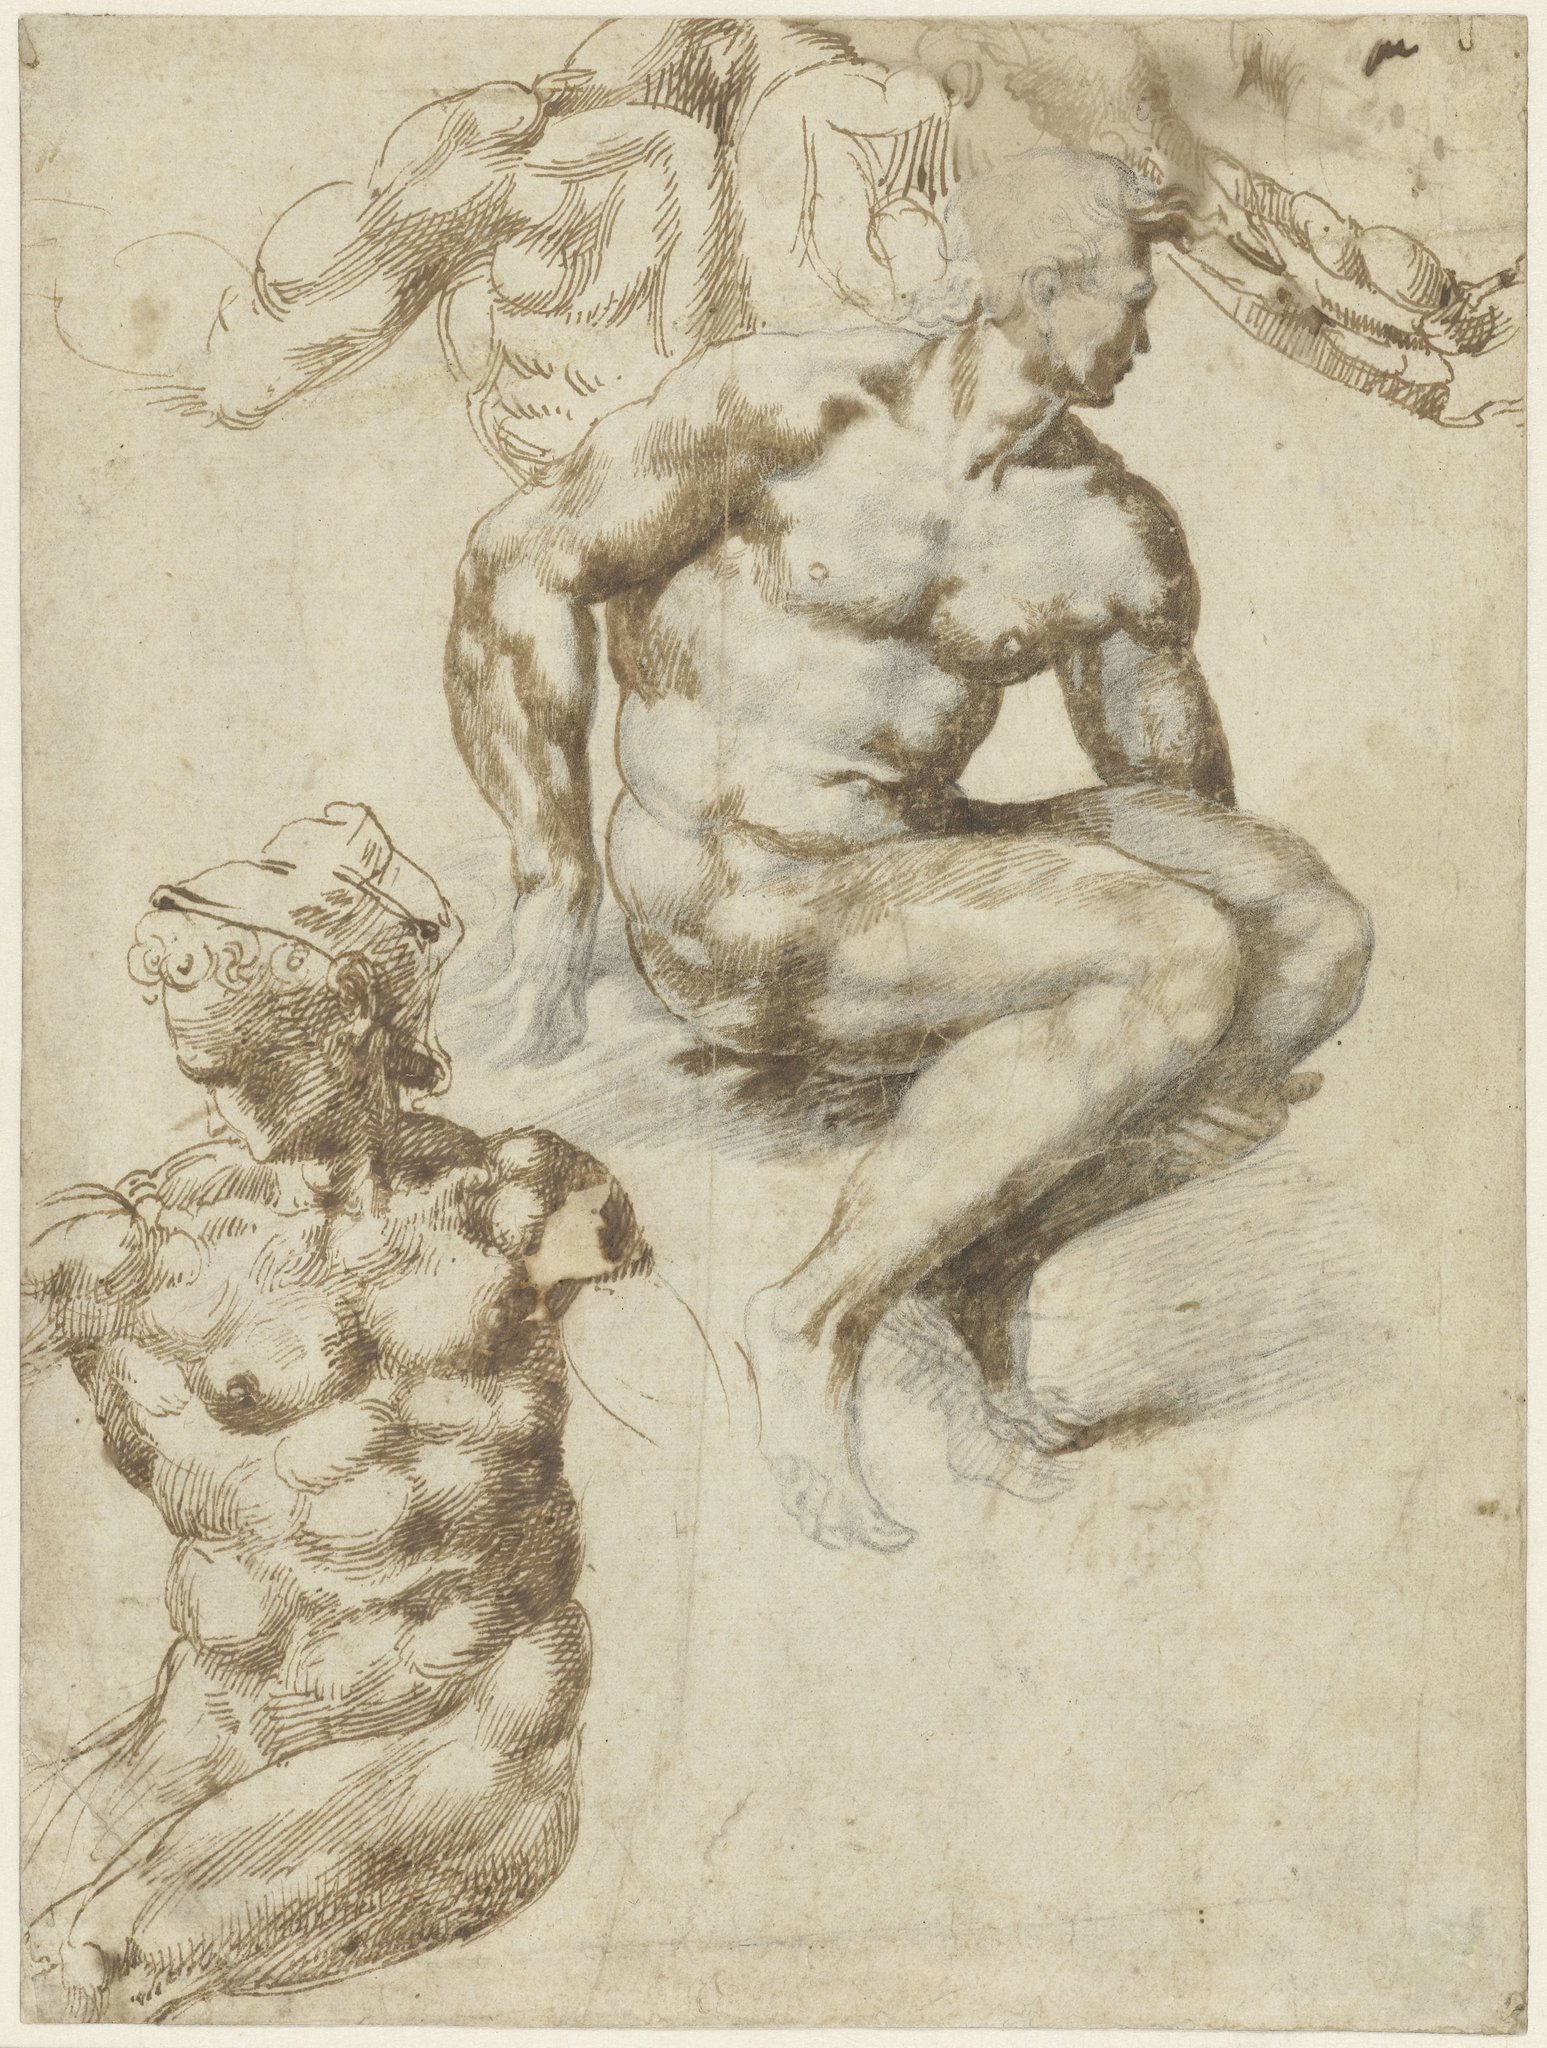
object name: drawing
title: Twee naakten en een rug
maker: Anonymous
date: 1600-1699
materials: chalk, ink, paper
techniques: pen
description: De figuurstudies zijn waarschijnlijk gebruikt voor twee ignudi in het plafond van de Sixtijnse kapel.